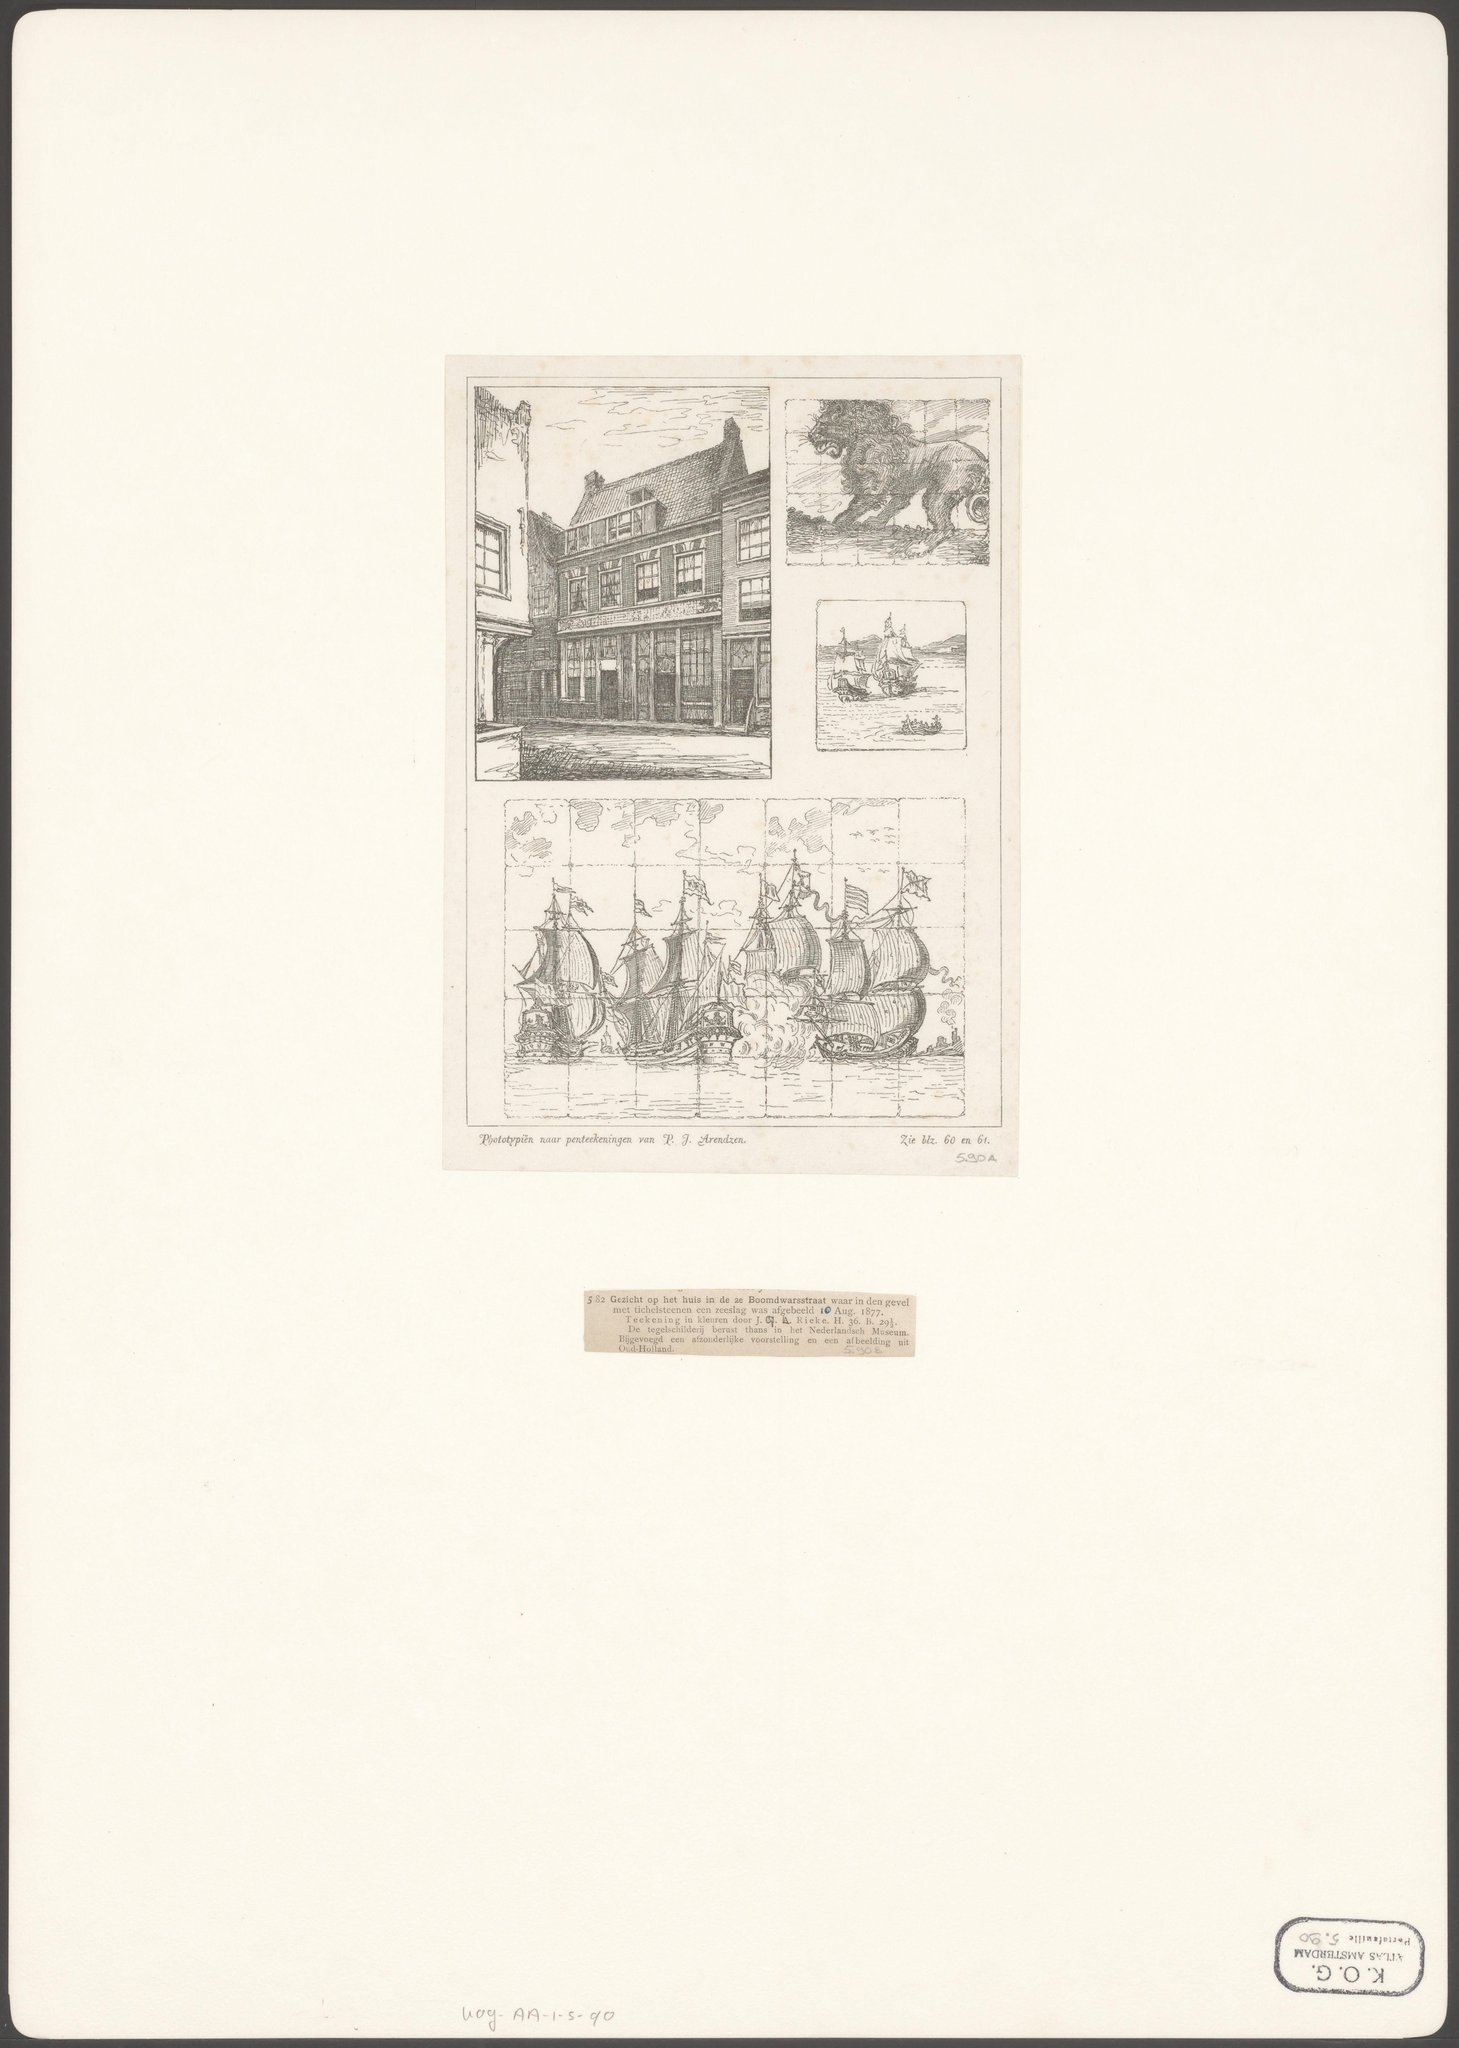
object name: photomechanical print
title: Gezicht op een huis aan de Tweede Boomdwarsstraat en tegels in de gevel die een zeeslag verbeelden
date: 1856-1950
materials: paper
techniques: letterpress printing, line block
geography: amsterdam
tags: stone tablet in façade, city-view in general; 'veduta', tiles, bricks ~ building material, the usual house or row of houses, façade (of house or building)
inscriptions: collector's mark: ‘5.90’ Lugt 1641b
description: Onderwerpsrubriek binnen de Atlas Amsterdam: Begijnensloot (Gedempte), Bagijnhofsteeg, Beulingsloot, Bickersgracht en –plein, Bickersstraat (Groote), Bilderdijkskade en -straat, Binnenkant, Blauwburgwal, Boomdwarsstraat, Brouwersgracht, Bleekersspad (Lange), Bleekerssloot, Bloemgracht, Boerenwetering, Boltensgrachtje, Boomssloot (Recht), Badhuisweg.